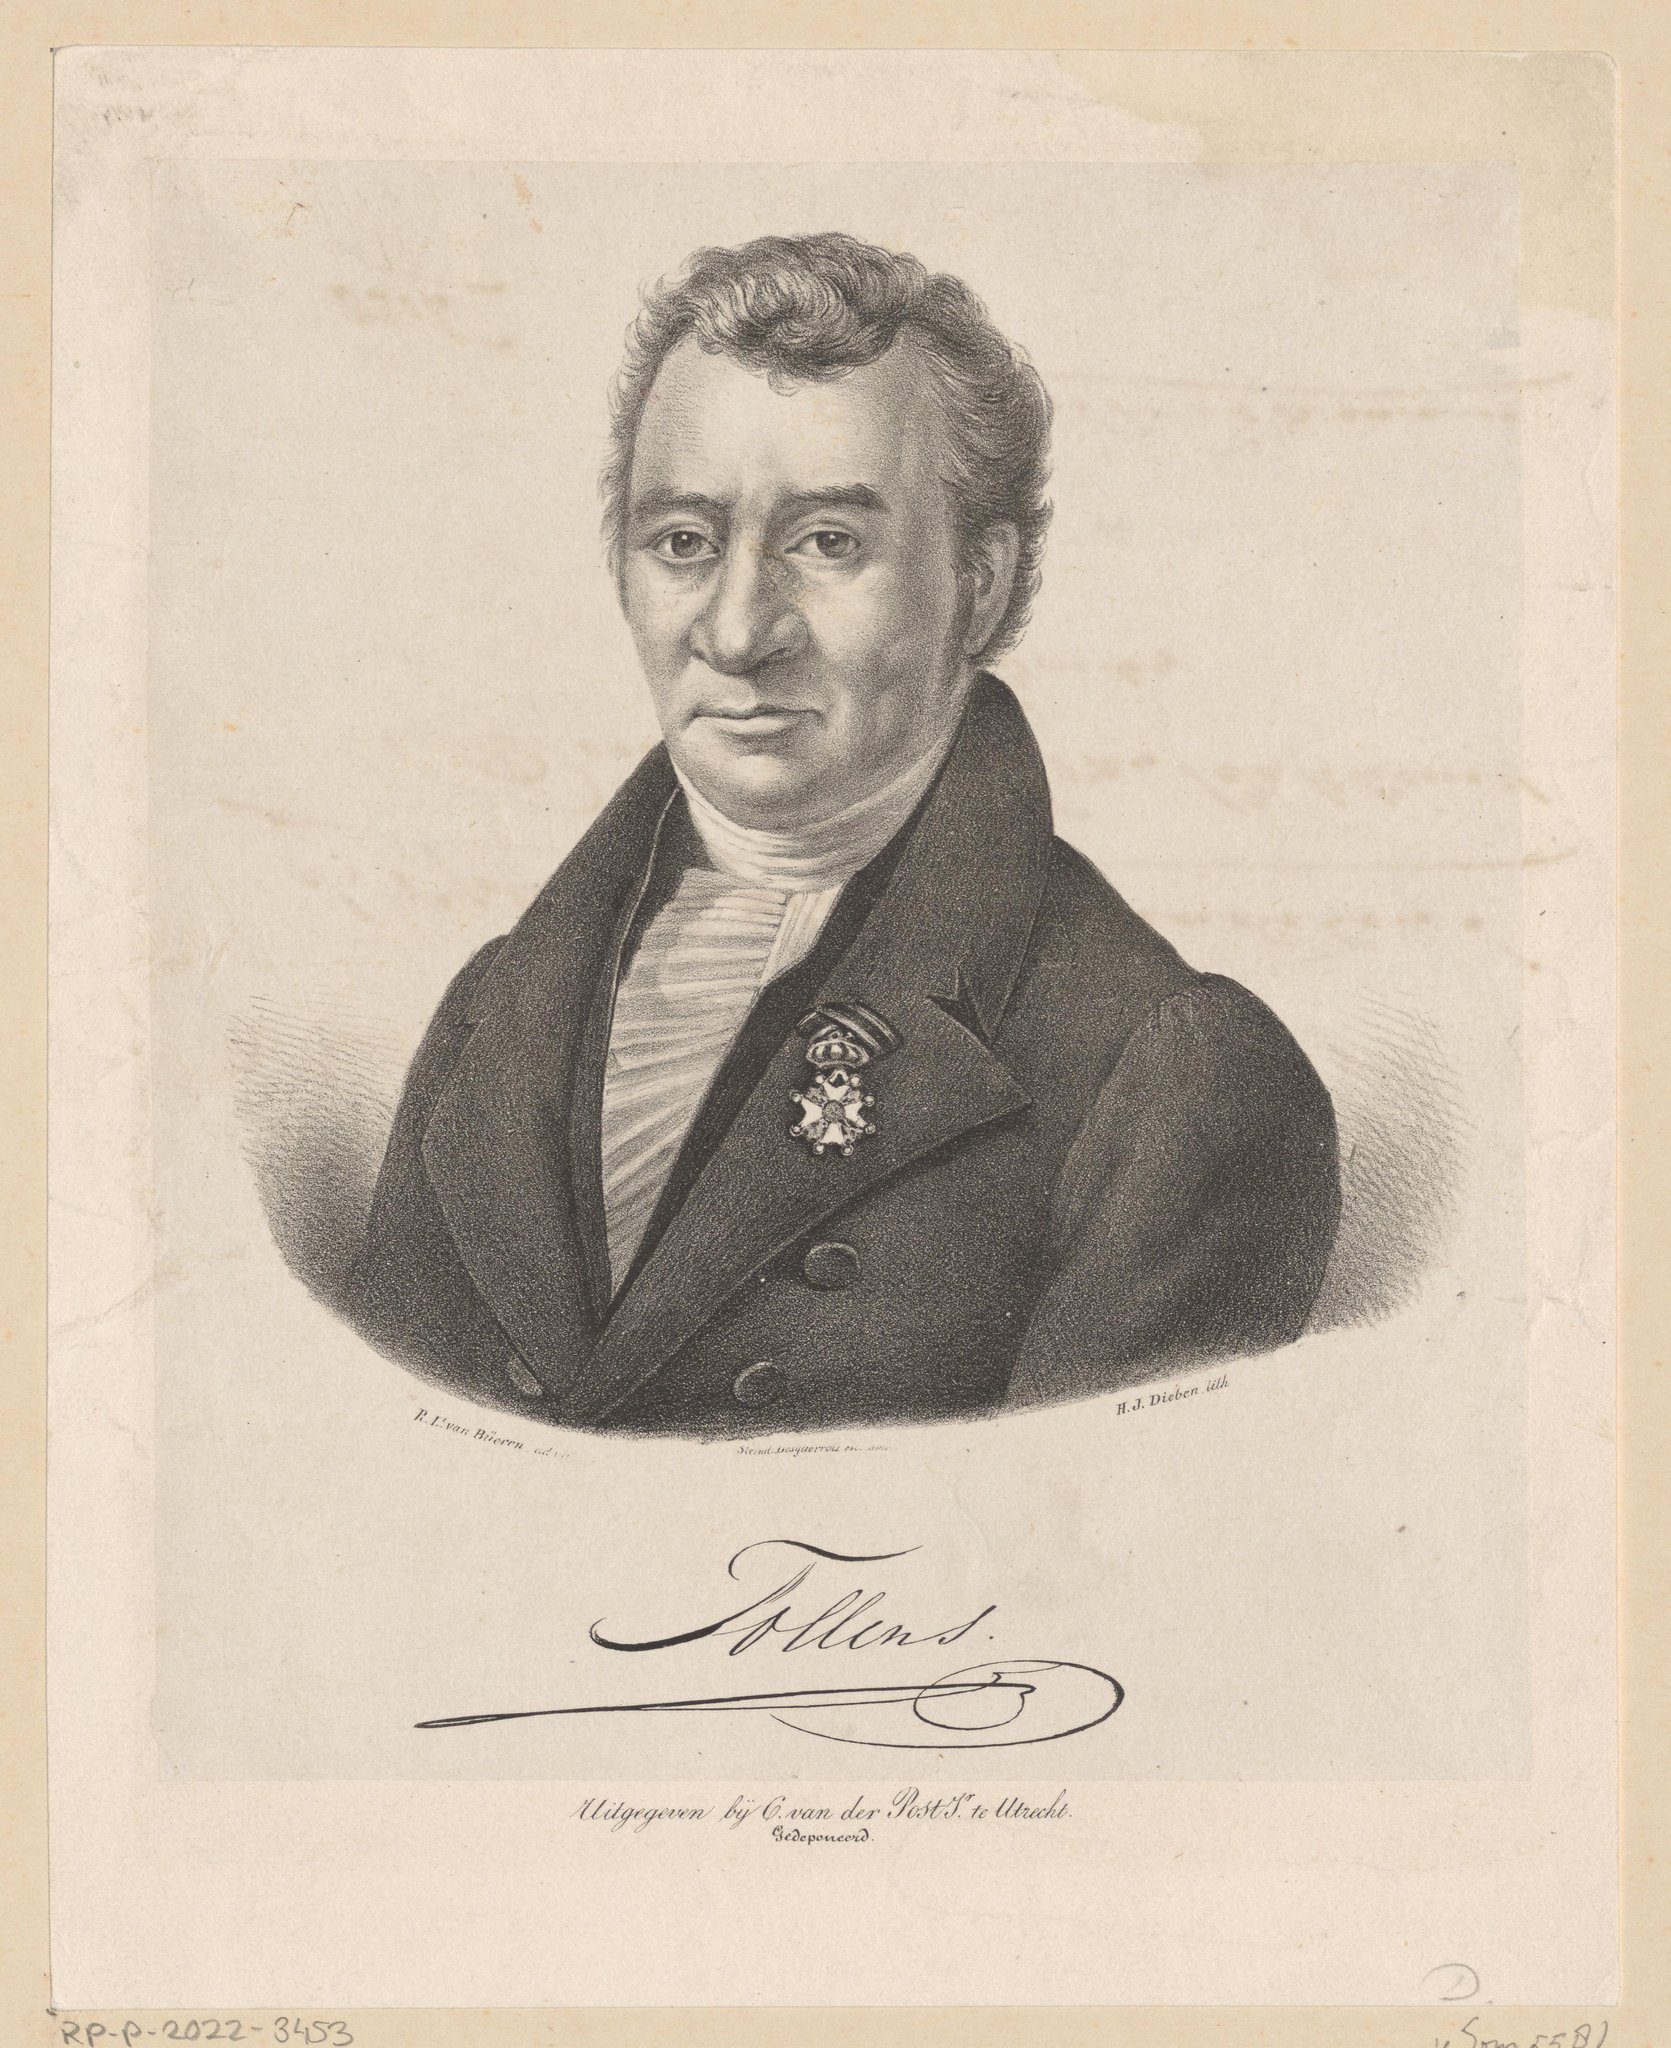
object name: print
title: Portret van Hendrik Tollens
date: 1830-1836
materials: paper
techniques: lithograph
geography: utrecht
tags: rotterdam, hendrik tollens, historical persons, portrait of a writer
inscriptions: collector's mark: Lugt 2228, inscription: ‘l. ?. voorzichtig behandelen. Den Heere L. van Bakkruid. Backs te Amsterdam. 031T.’, : ‘Gedeponeerd.’